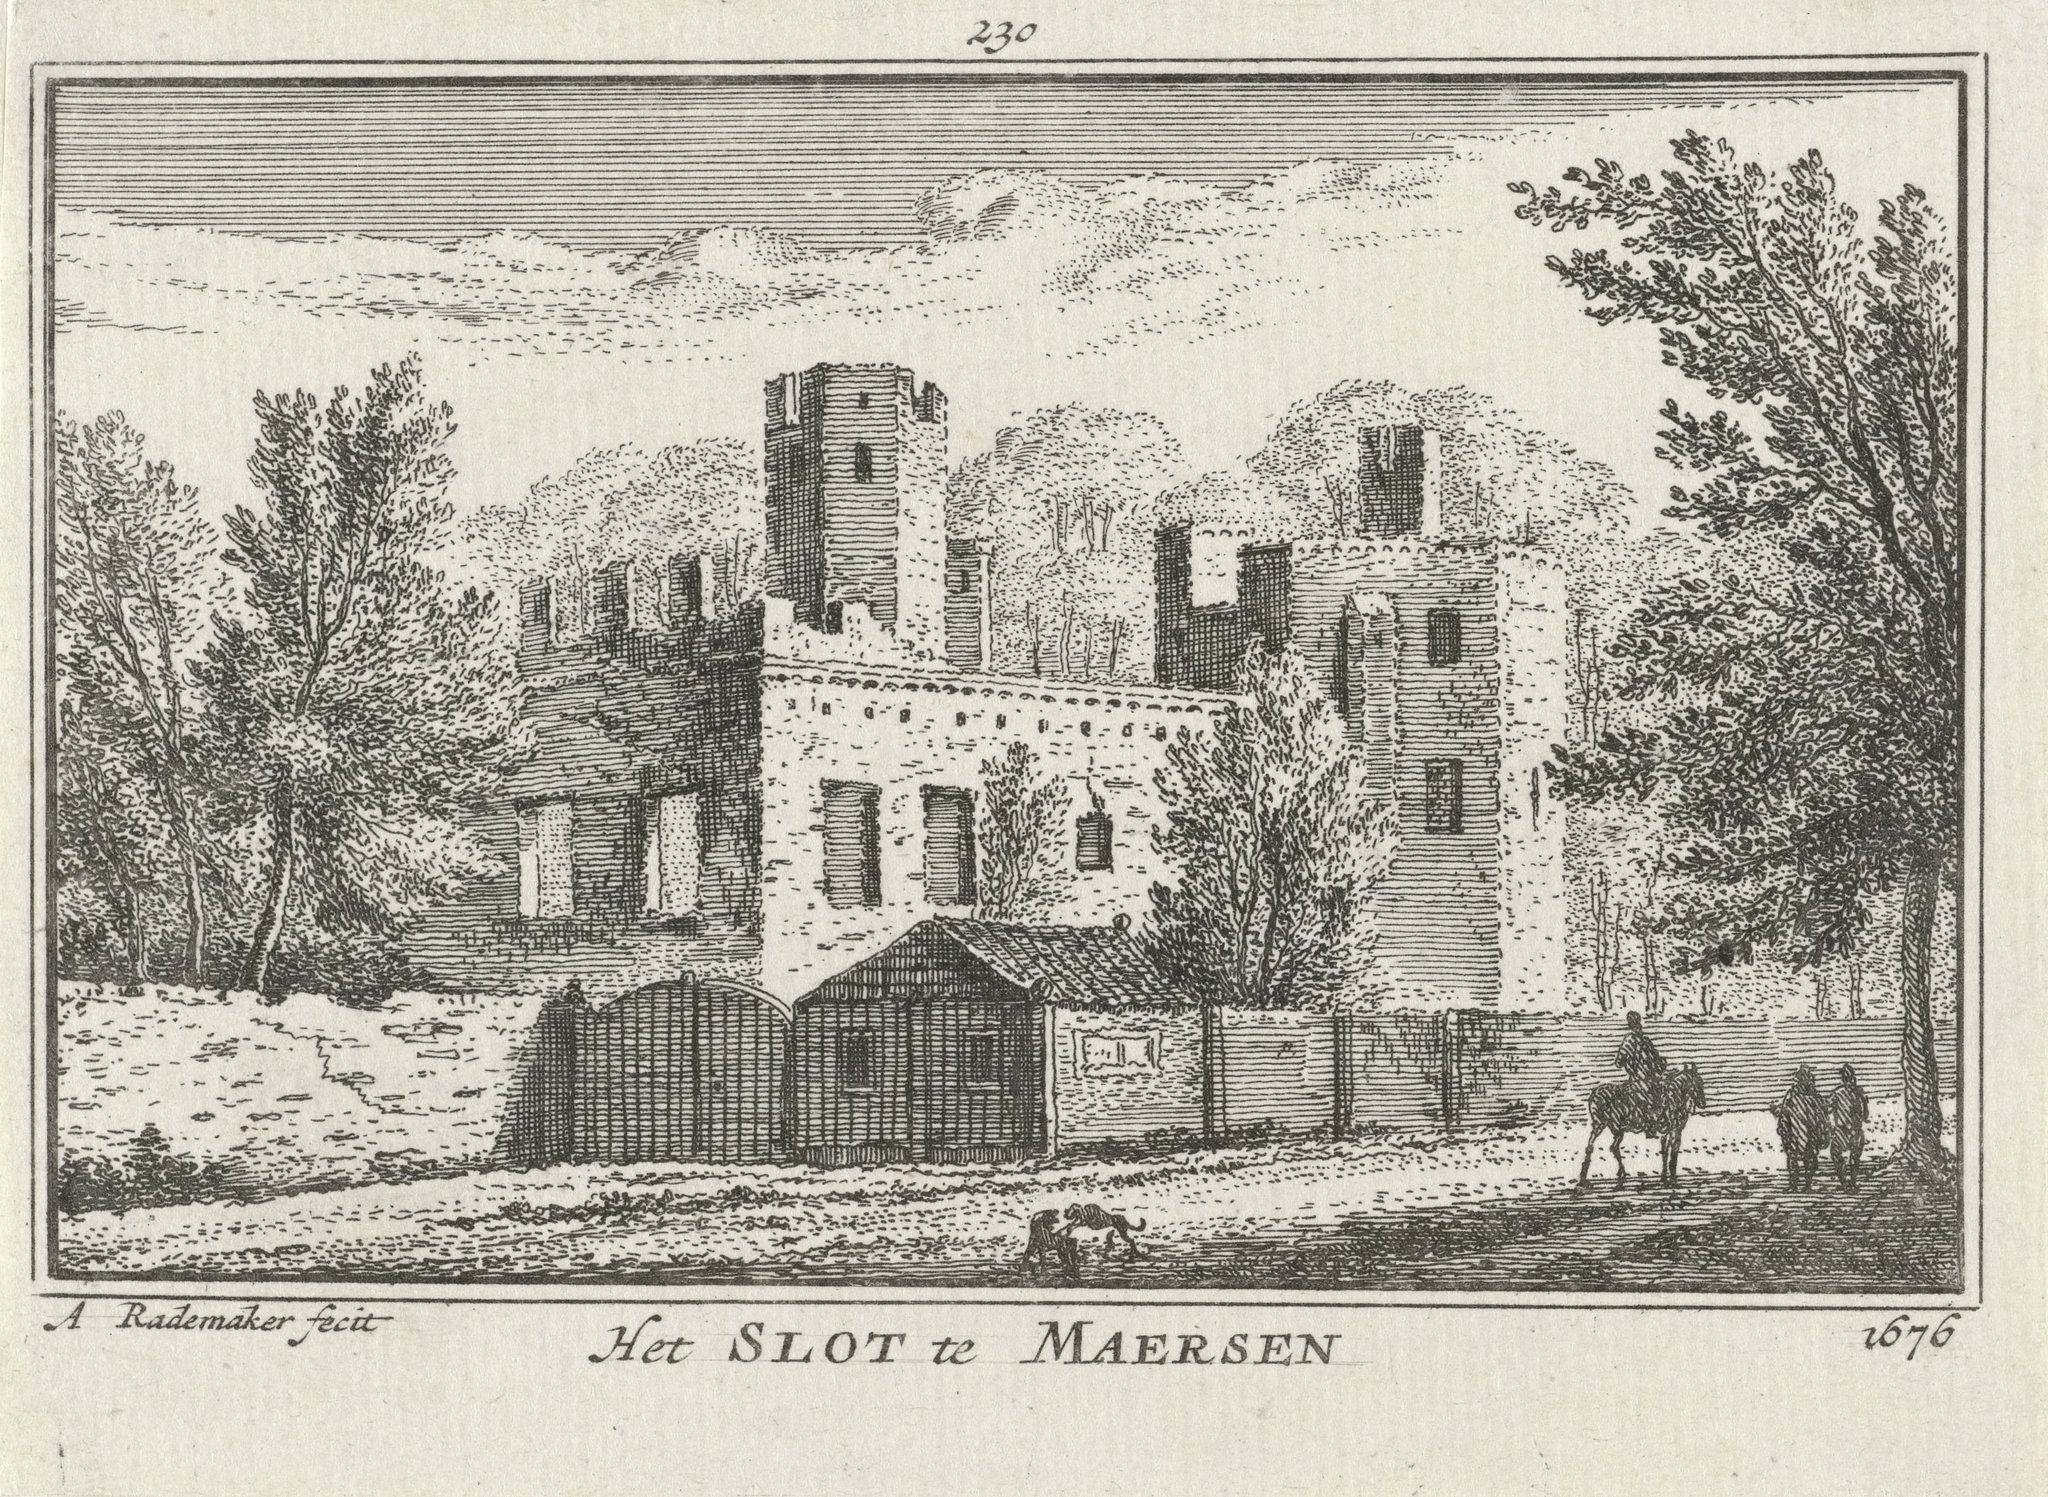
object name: print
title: Gezicht op de ruïne van Huis Ter Meer bij Maarssen, 1676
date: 1727-1733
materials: paper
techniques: engraving, etching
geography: amsterdam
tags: riding a horse, ass, or mule; rider, horseman, castle, 'en route', traveller under way, dog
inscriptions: collector's mark: Lugt 2228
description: Illustratie uit: Abraham Rademaker, Matthaeus Brouërius van Niedek, Isaac Le Long, Kabinet van Nederlandsche en Kleefsche outheden en (...) voorname stads- en landgebouwen, Willem Barents en Antoni Schoonenburg: Amsterdam, 1727-1733, ill. nr. 230.